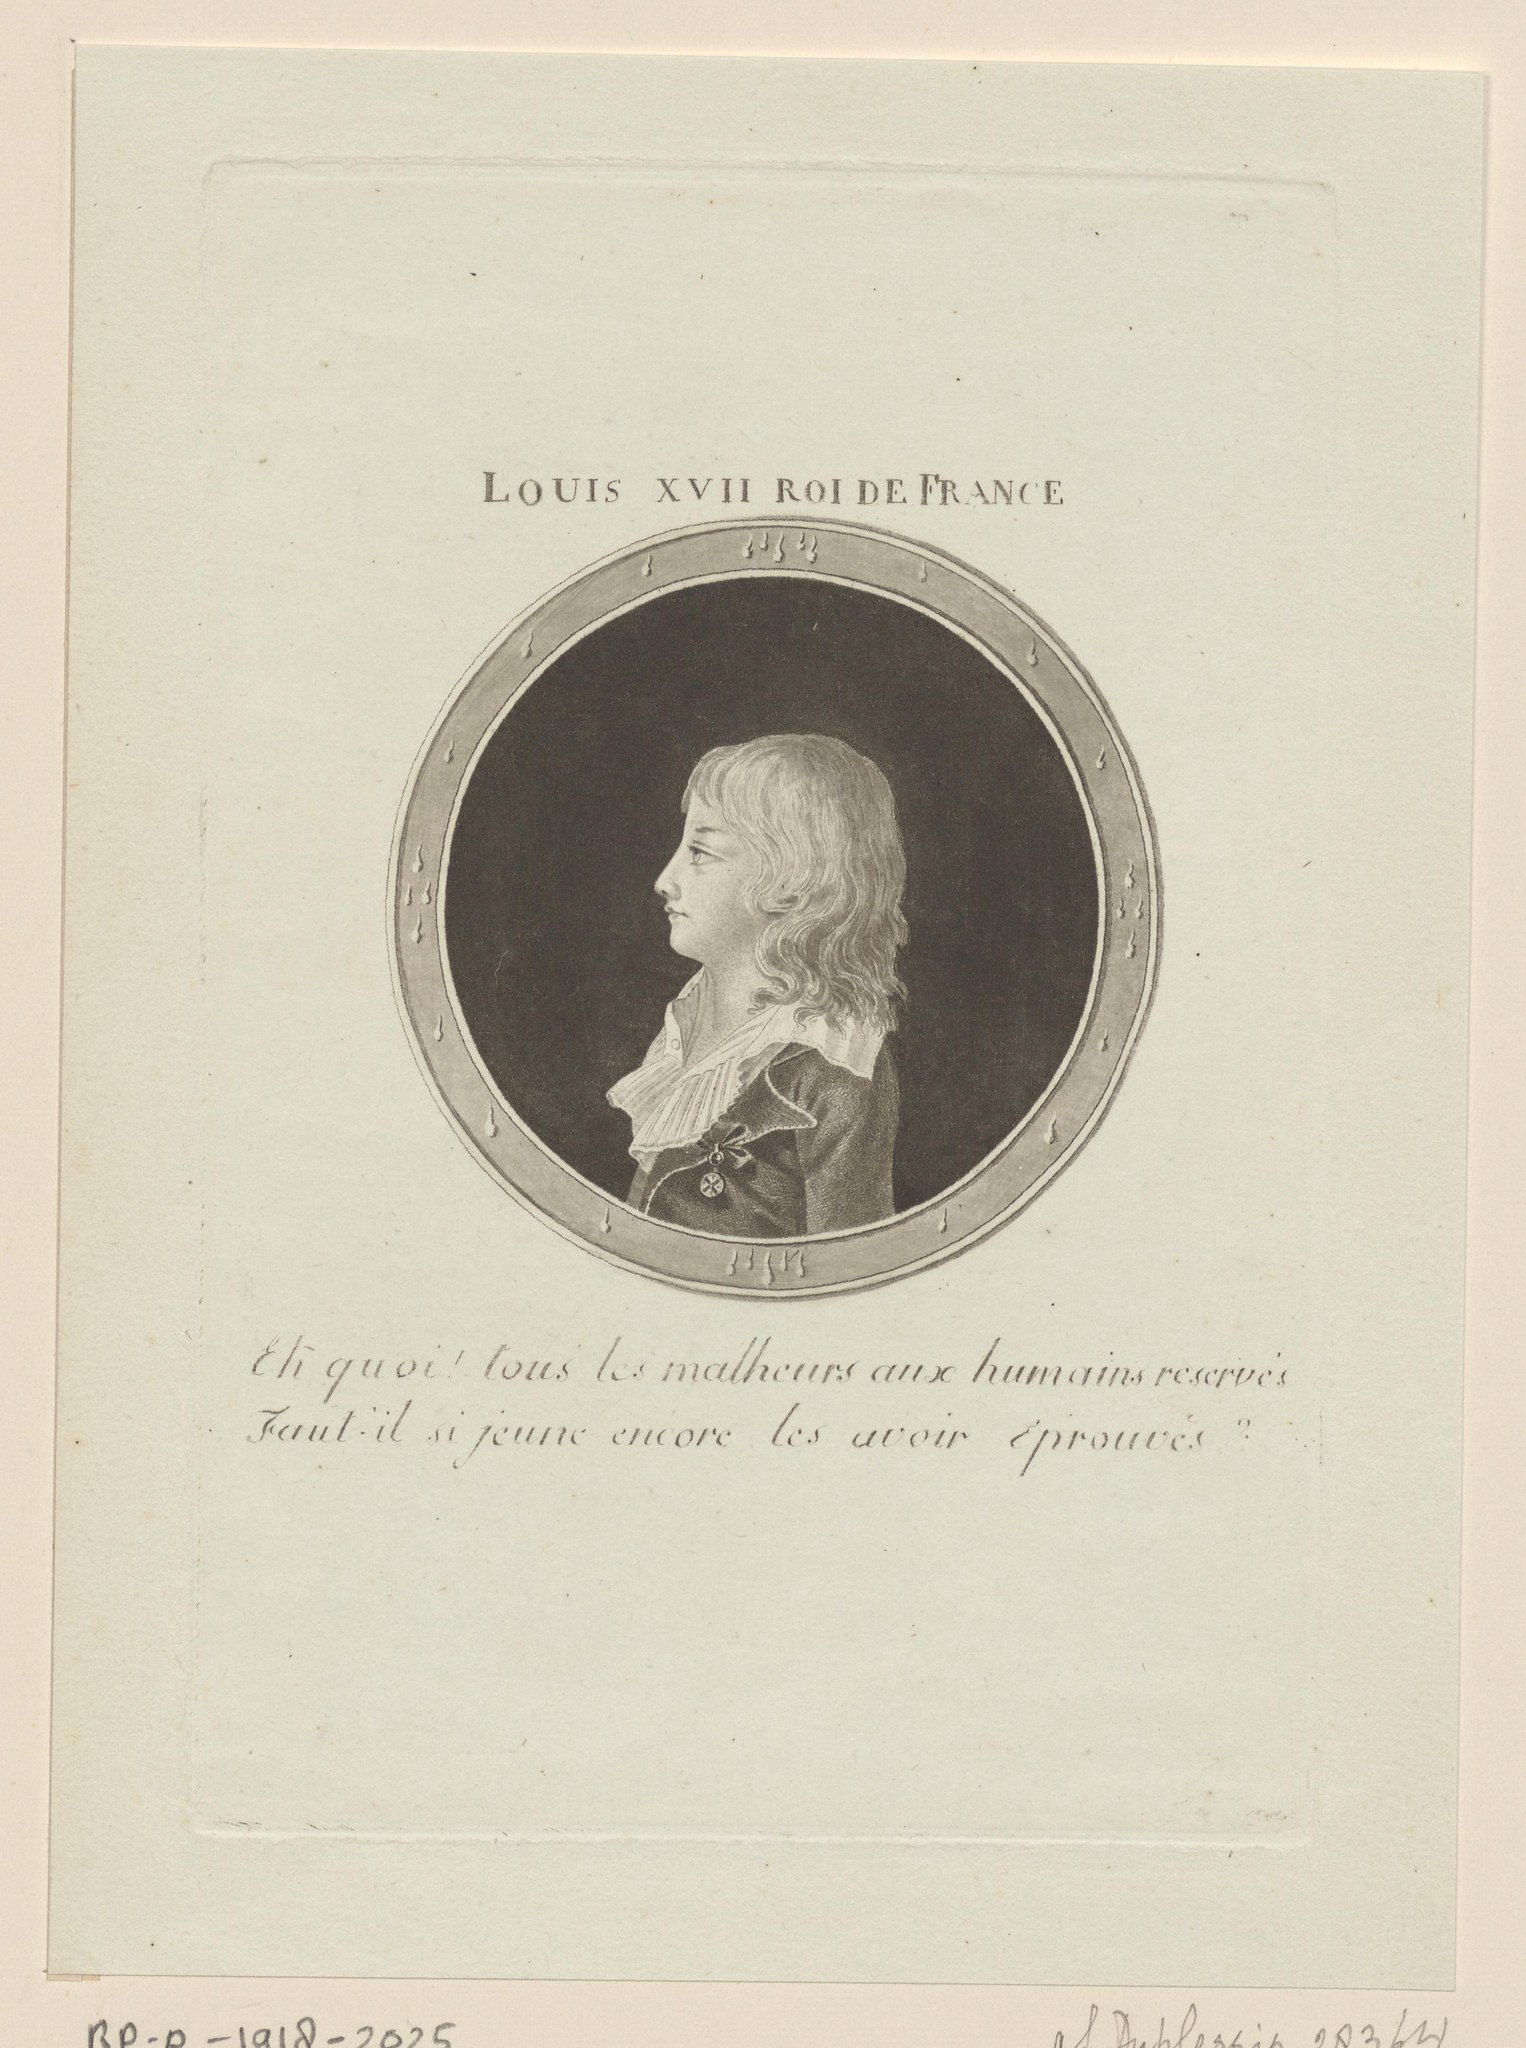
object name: print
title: Portret van Lodewijk XVII van Frankrijk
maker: Anonymous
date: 1793-1795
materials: paper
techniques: aquatint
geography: france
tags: historical persons, king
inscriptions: collector's mark: Lugt 2233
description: Met tweeregelig onderschrift in het Frans uit Voltaire's Mérope.